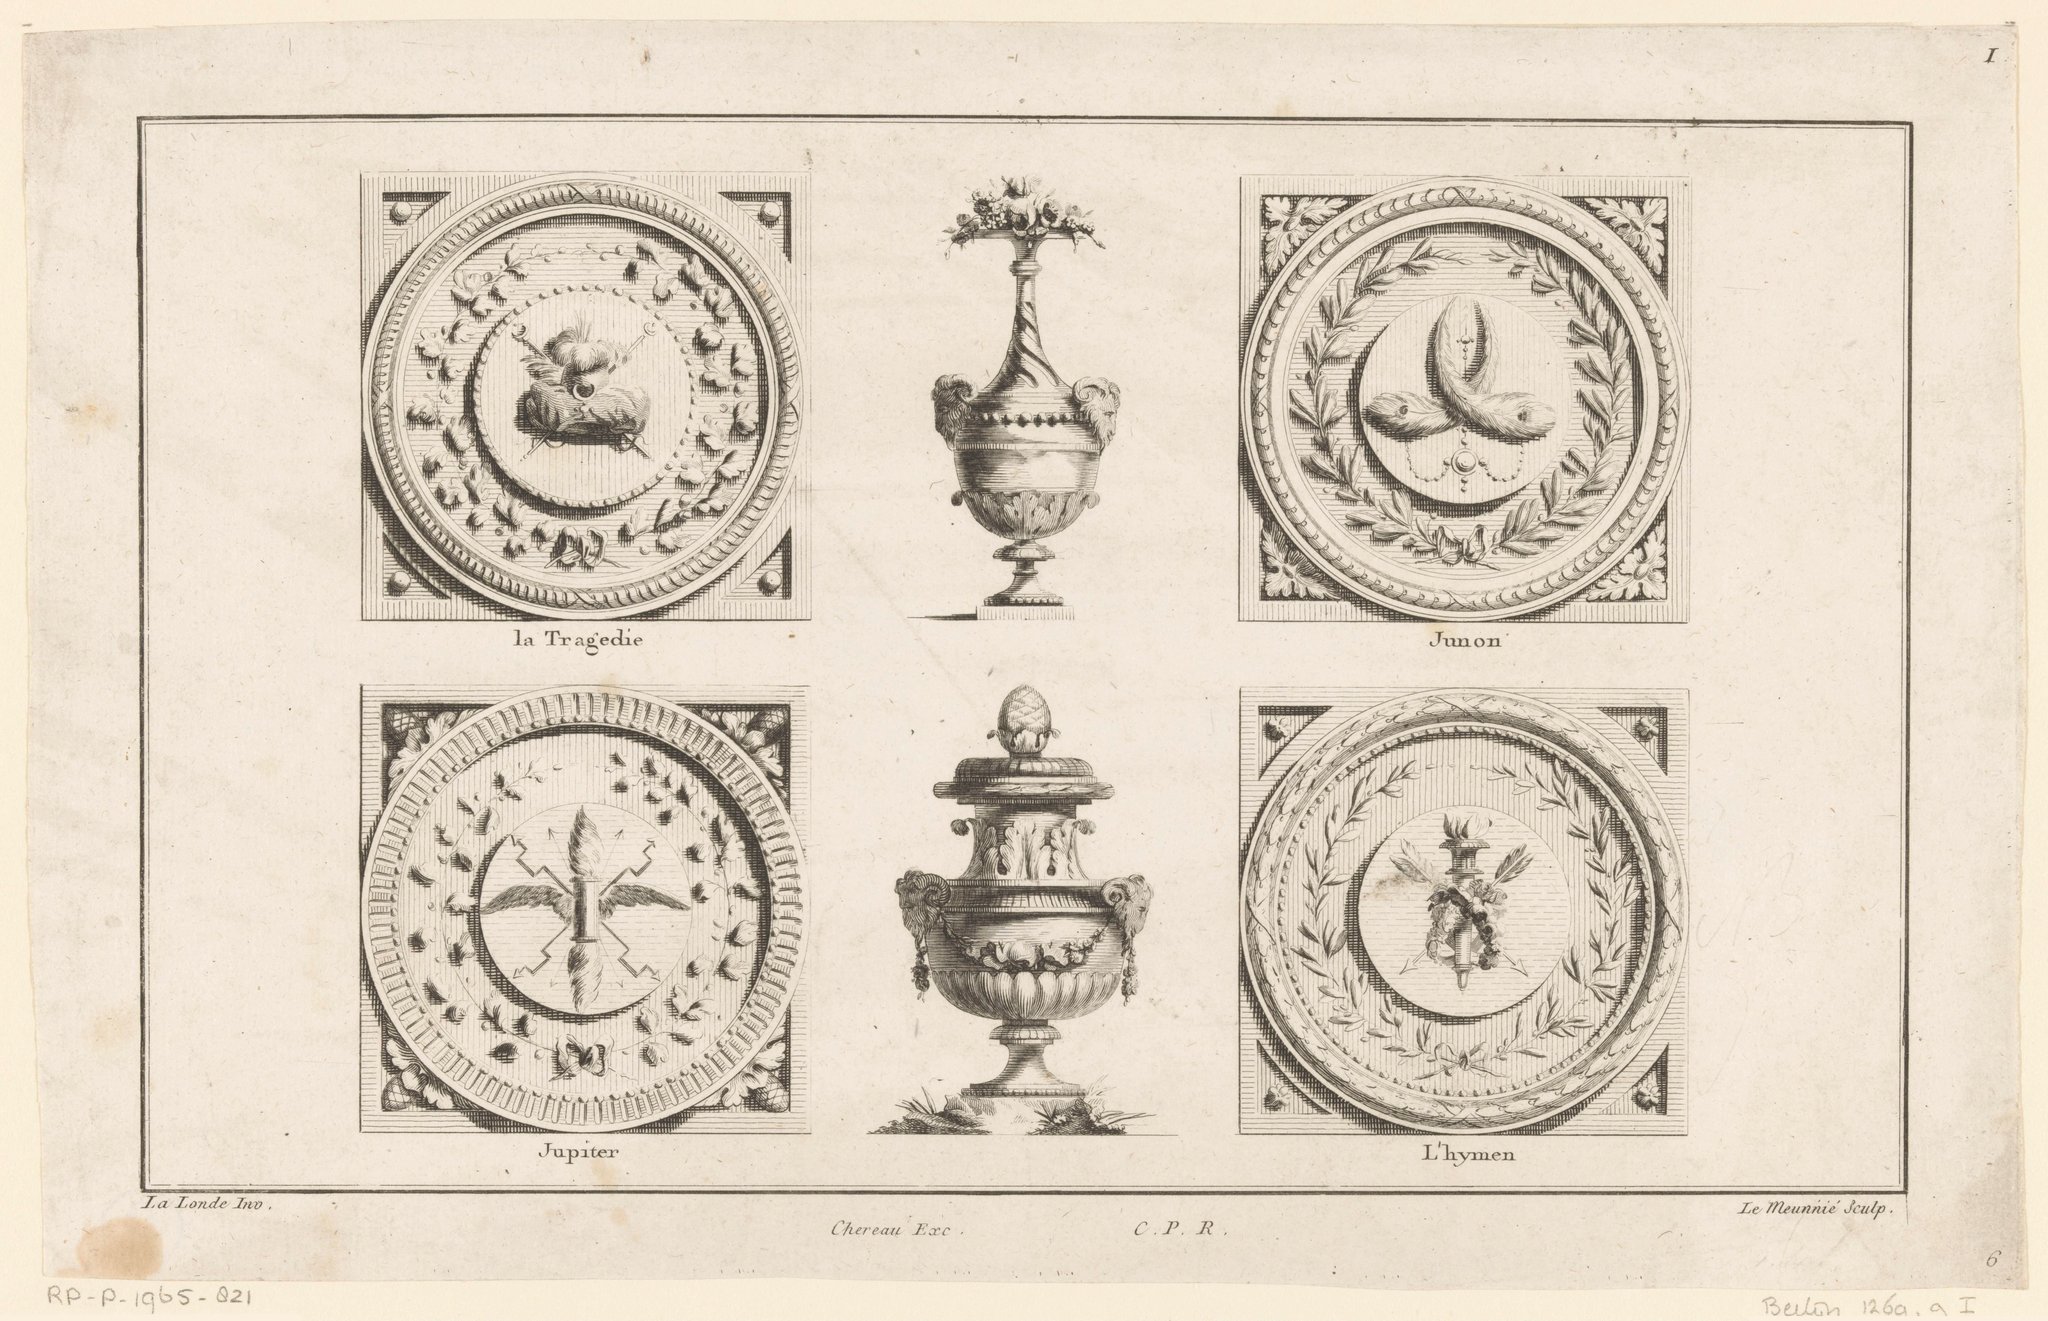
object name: print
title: la Tragedie, Junon, Jupiter, L'hymen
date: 1784-1785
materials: paper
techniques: engraving, etching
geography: paris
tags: (story of) hymen(aeus), (story of) juno (hera), (story of) jupiter (zeus), 'tragedia' (ripa)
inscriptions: collector's mark: Lugt 2760, collector's mark: Lugt 2228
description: Vier soffieten als trofeeën en twee vazen. Links boven tragedie met een hoed en staven, rechts boven Juno met pauwenveren, links onder Jupiter met gevleugelde scepter en bliksemschichten, rechts onder Hymen met een fakkel, pijlen en kransen.